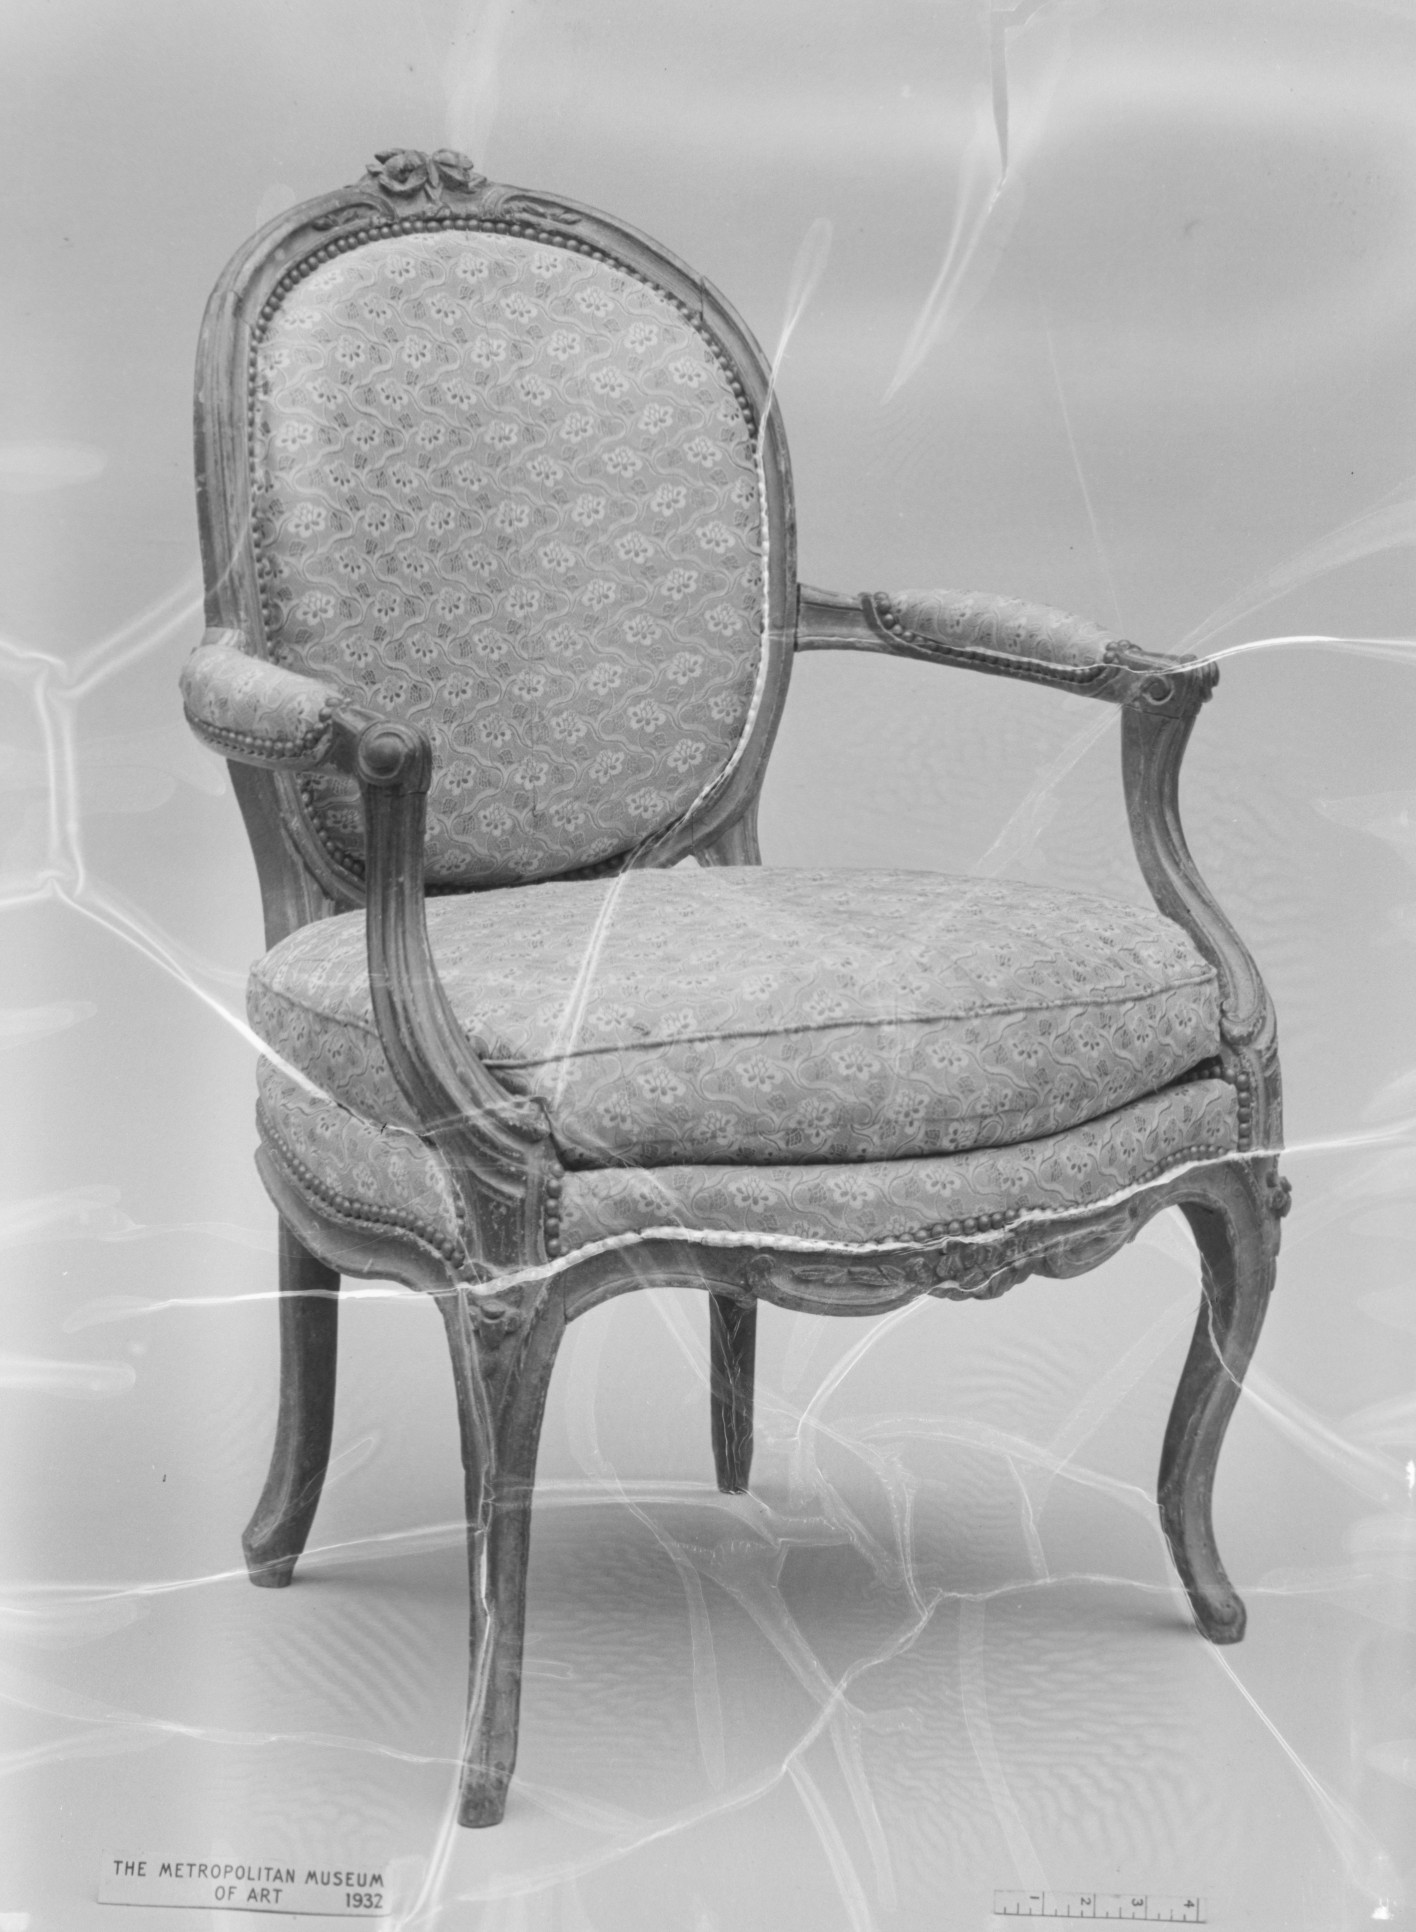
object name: armchair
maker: charles vincent bara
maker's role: maker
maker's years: 1754-1780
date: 1701-1800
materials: wood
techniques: carving